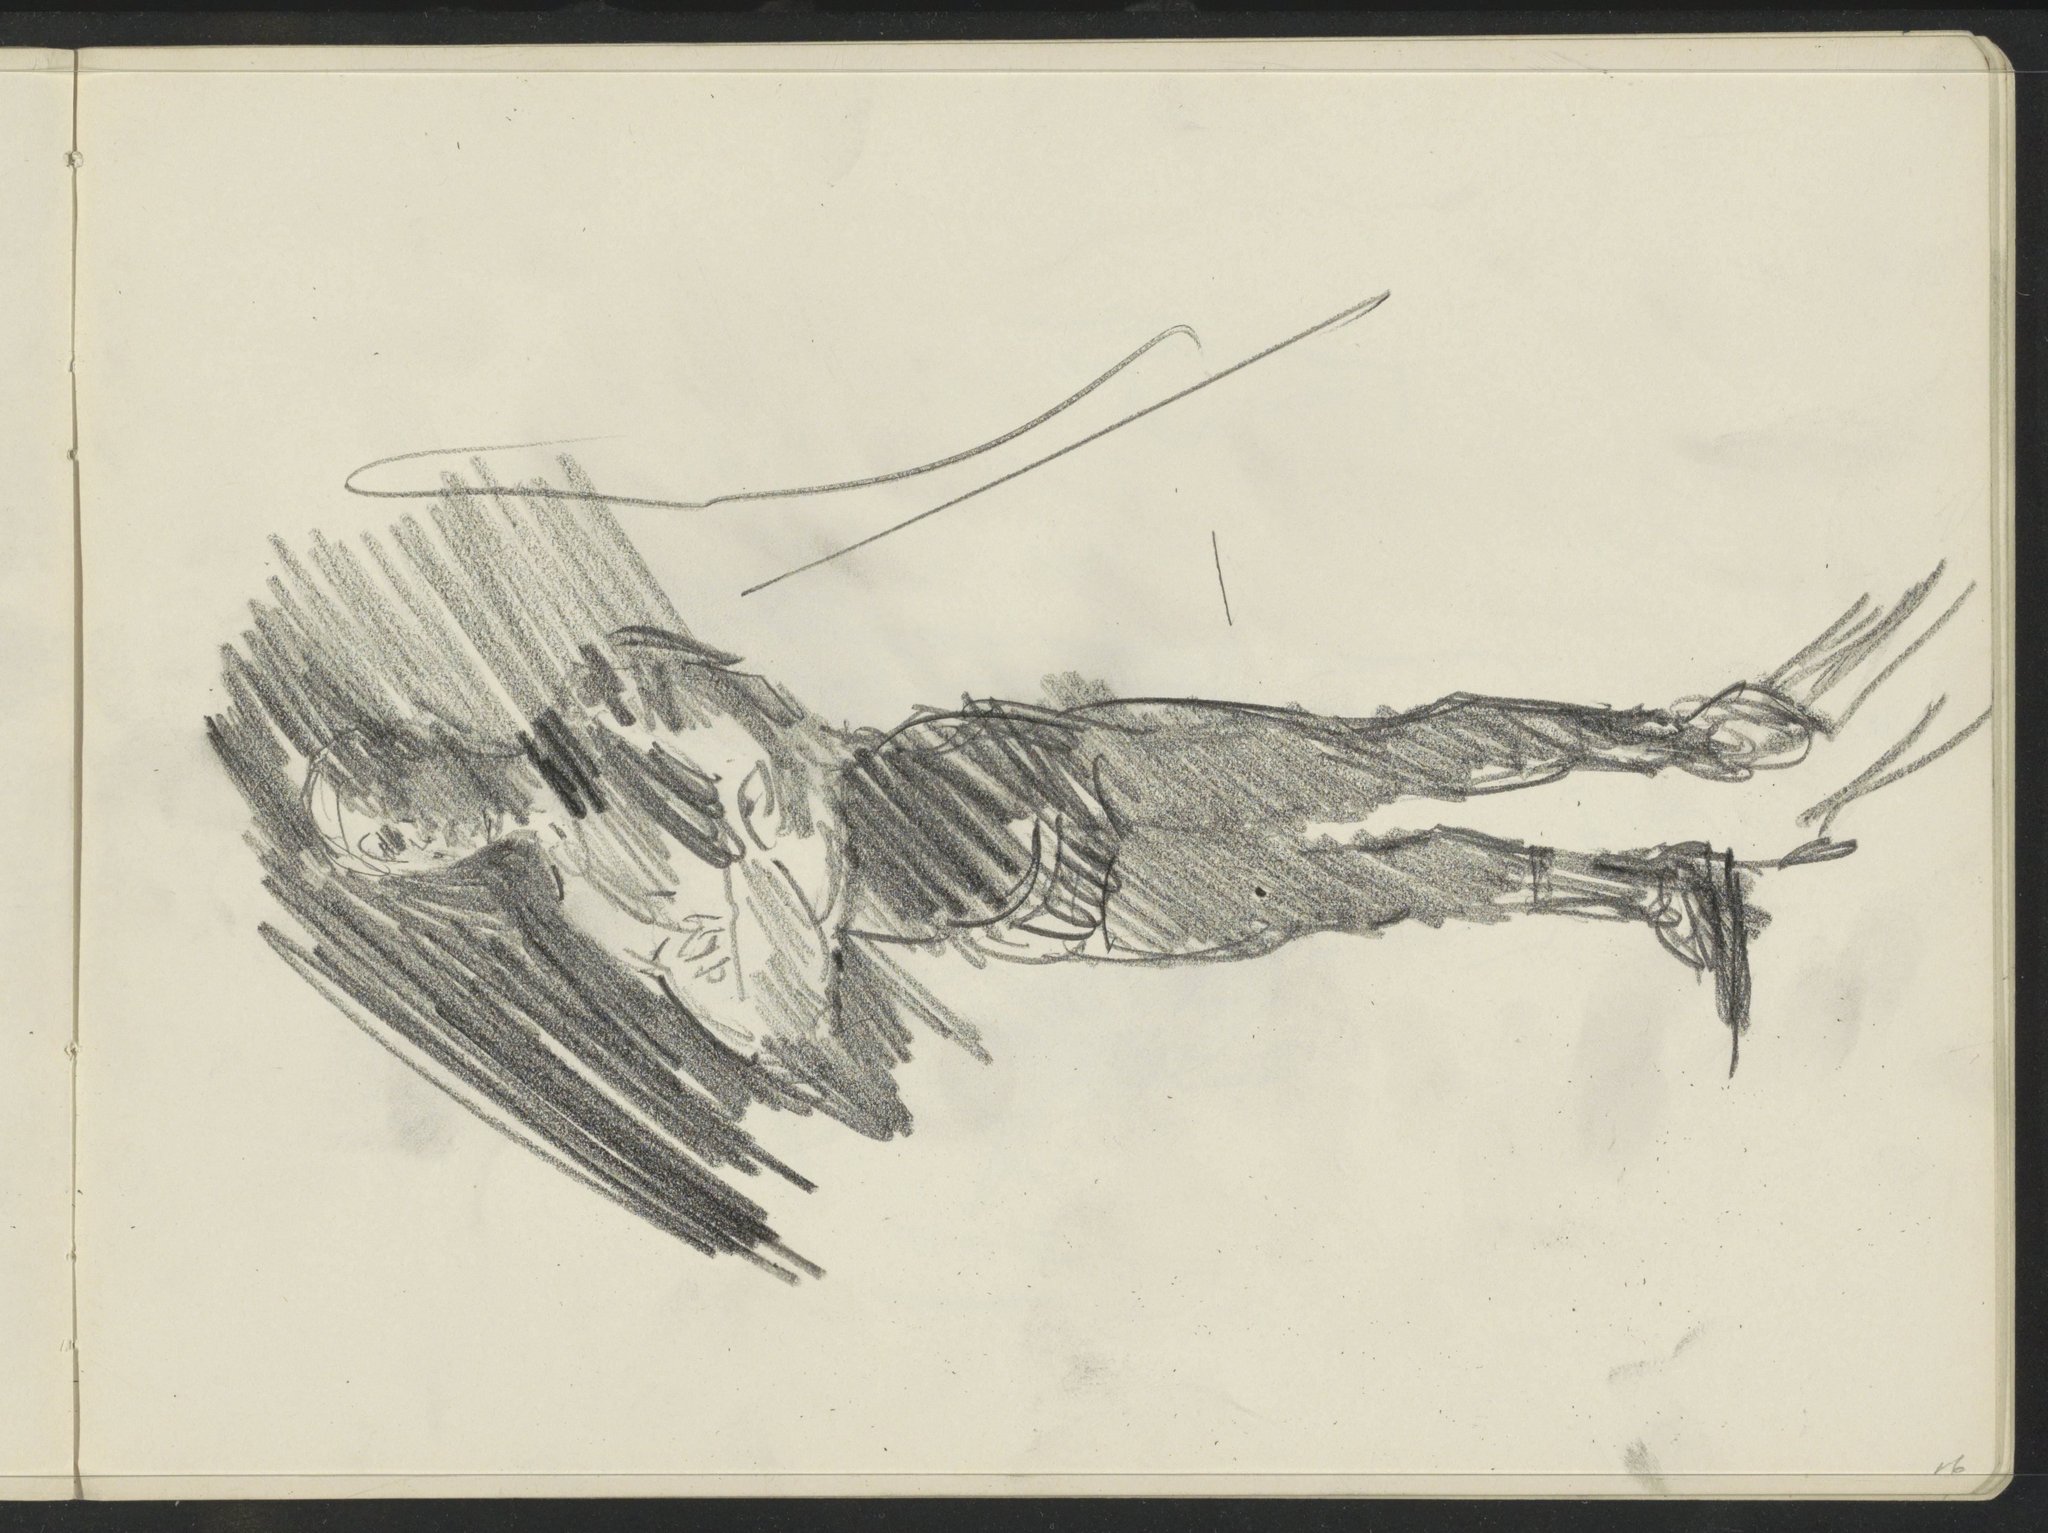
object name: sketchbook leaf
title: Staande man met de armen over elkaar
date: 1915-1934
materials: paper, pencil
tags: arms crossed, adult man (+ standing)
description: Blad 16 recto uit schetsboek XVI met 32 bladen.